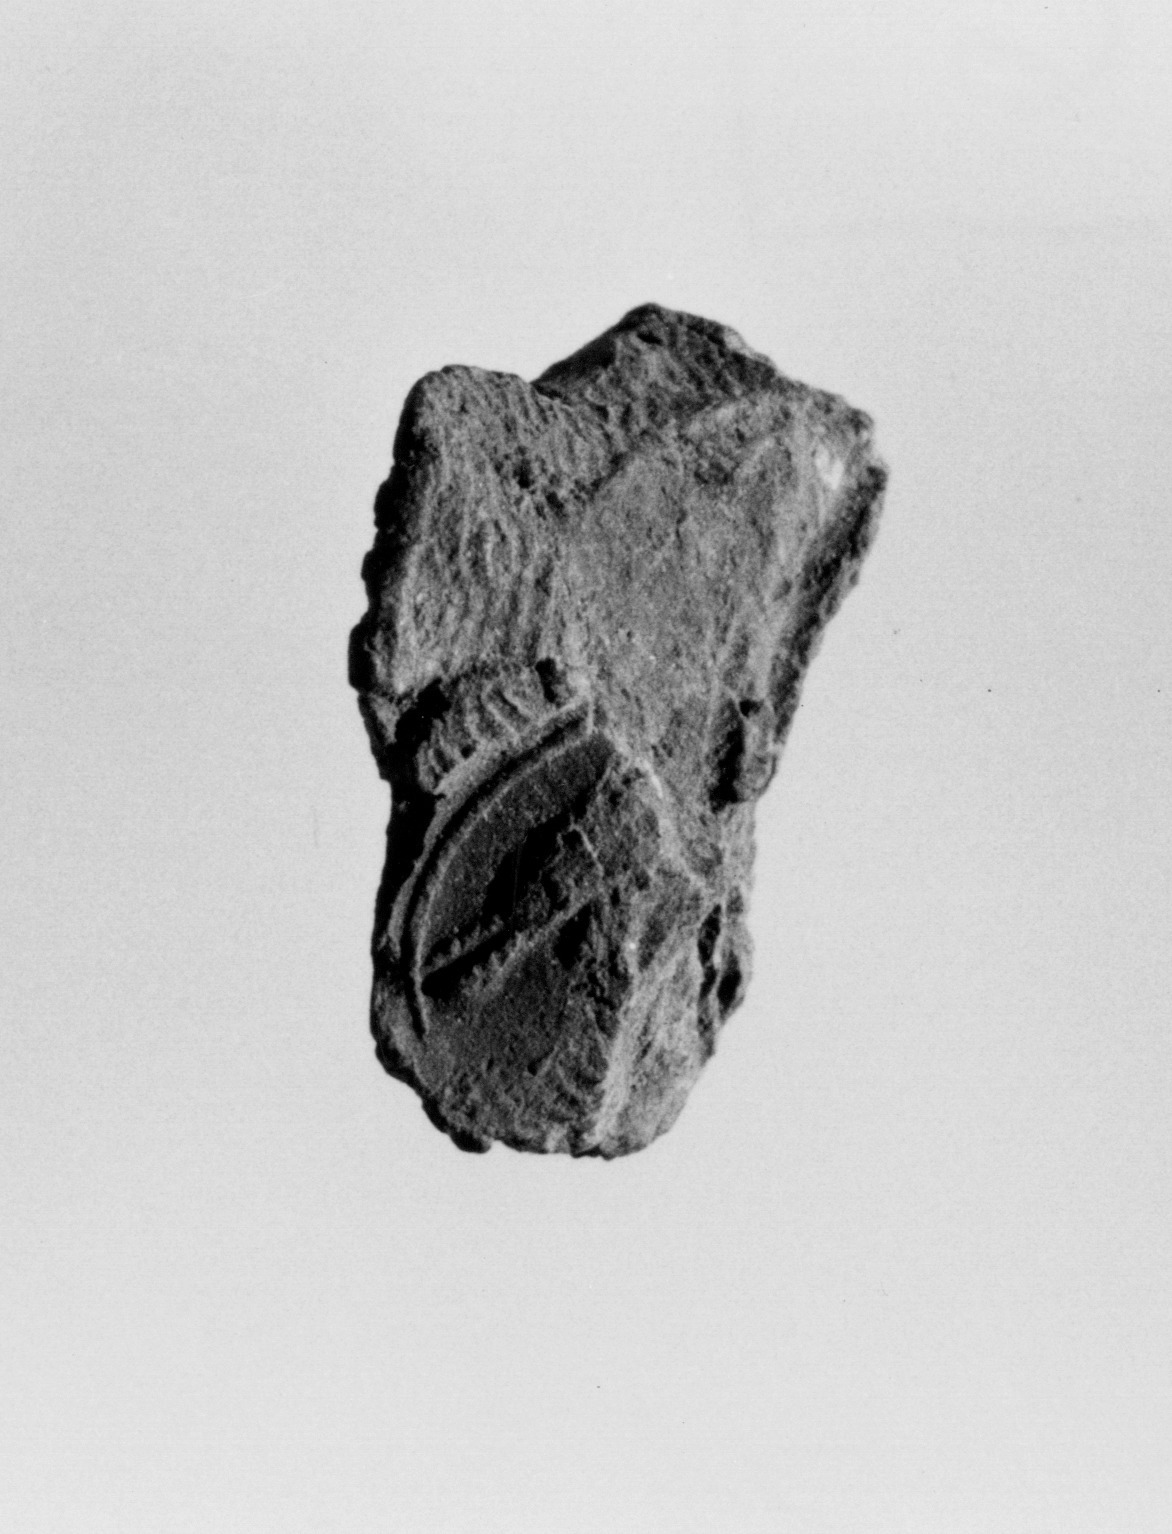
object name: sealing, nebmaatre, amenhotep iii, horus, falcon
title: Document Sealing With the Throne Name of Amenhotep III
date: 1390-1352 BCE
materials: mud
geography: egypt